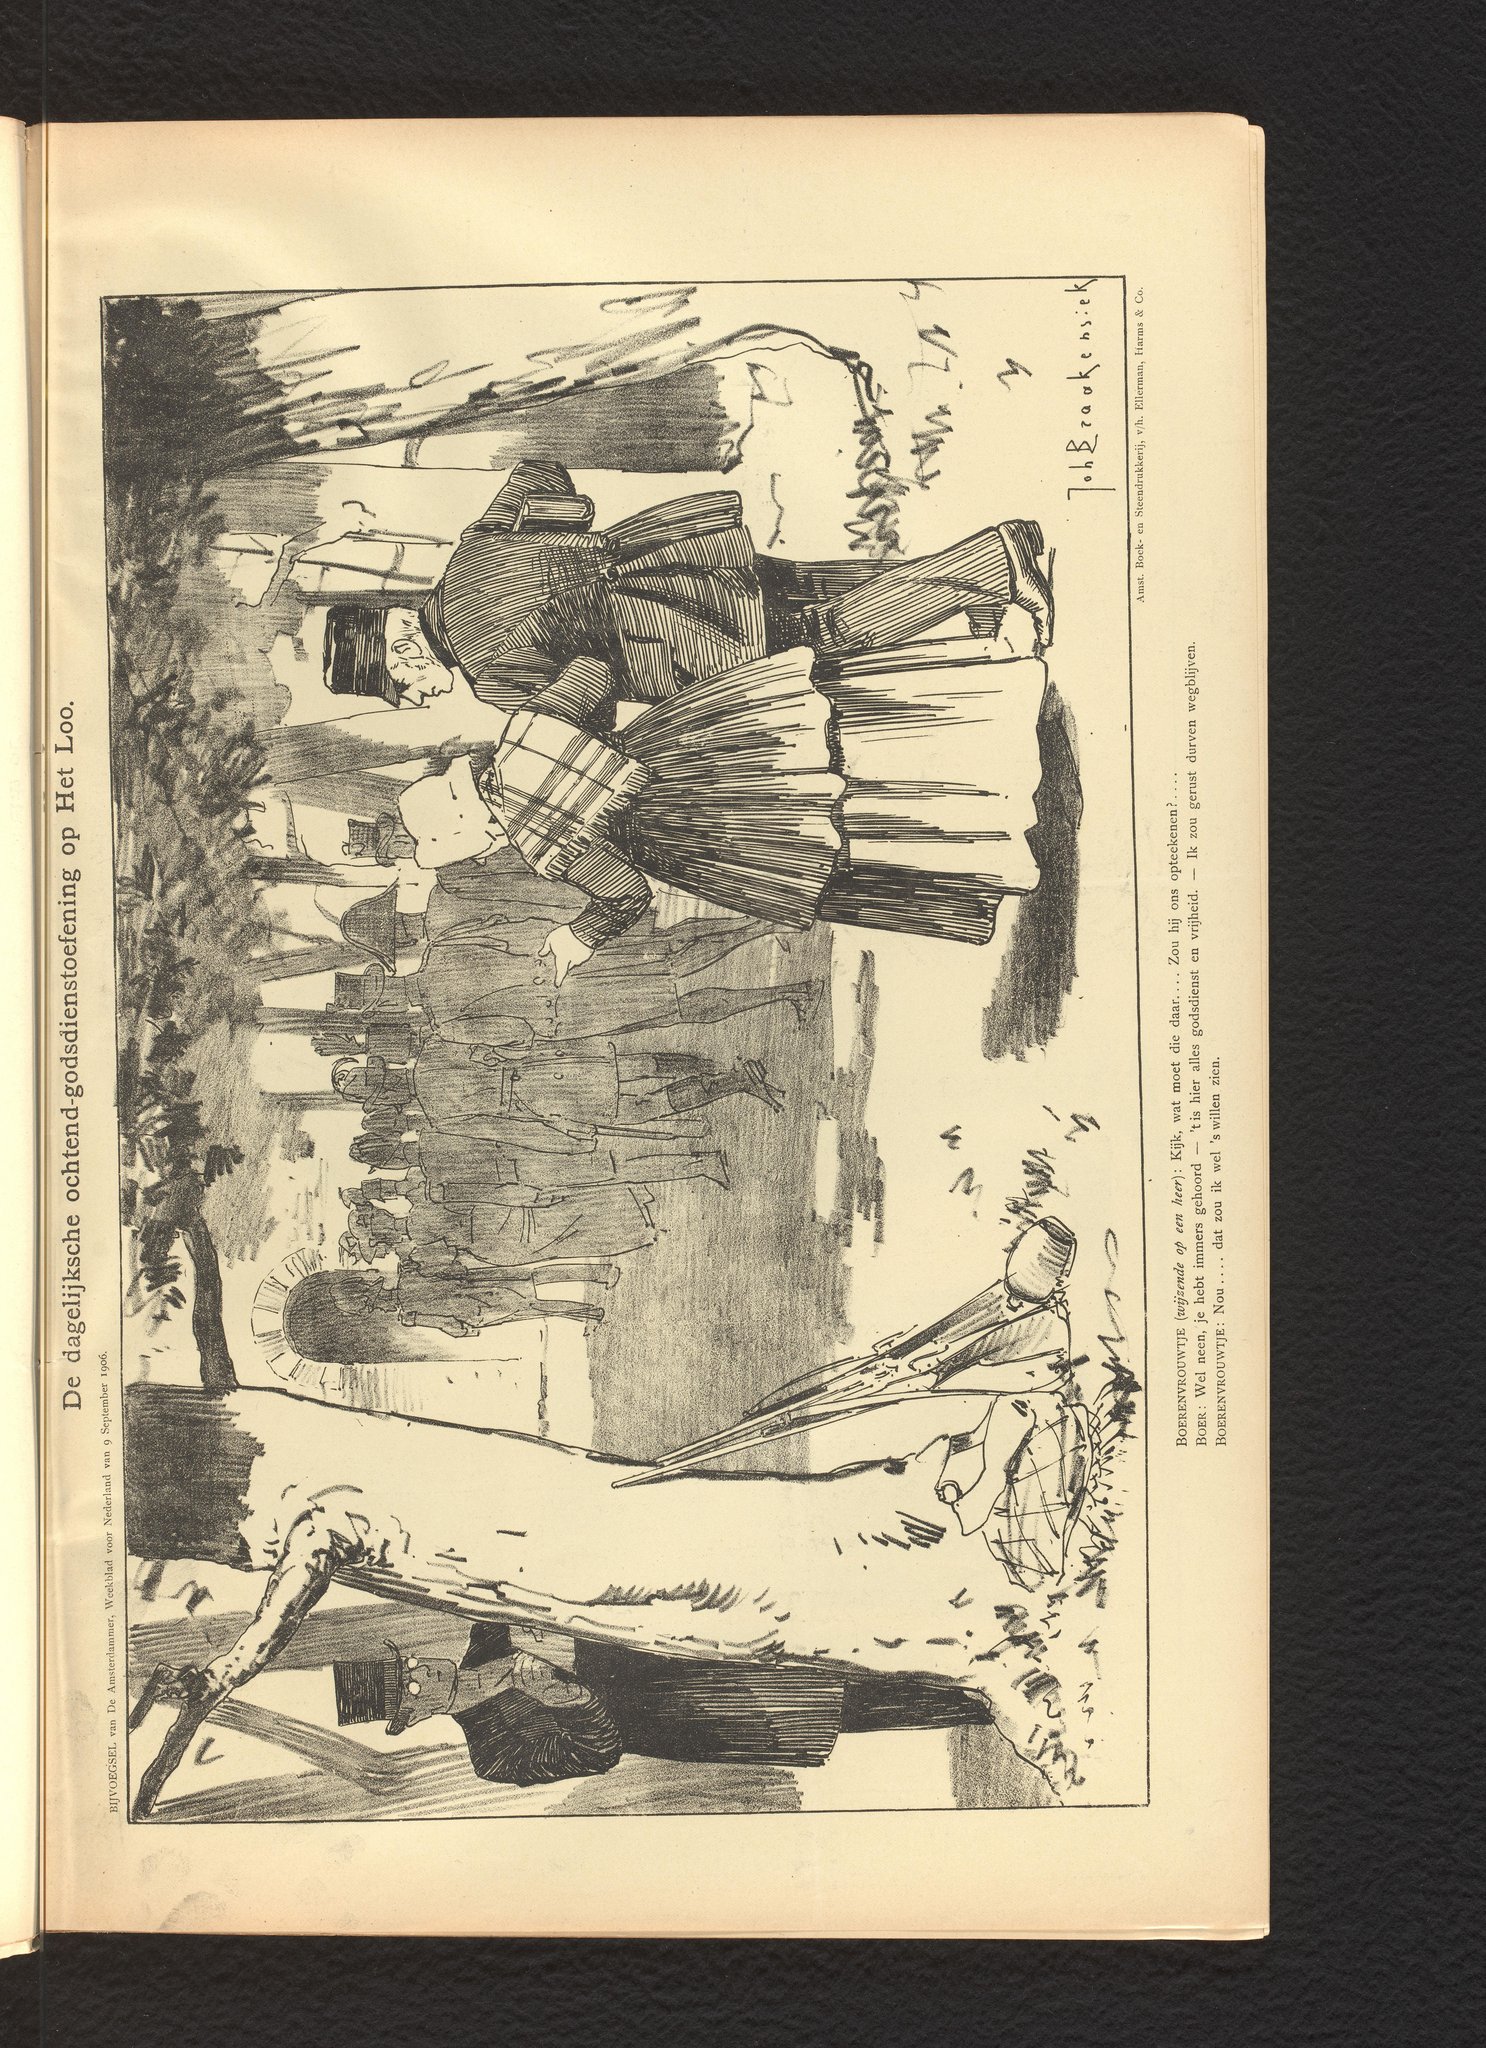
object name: cartoon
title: De dagelijksche ochtend-godsdienstoefening op Het Loo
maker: johan braakensiek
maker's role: draughtsman, print maker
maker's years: 1858-1940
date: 1906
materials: paper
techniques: lithograph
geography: amsterdam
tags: going to church, political caricatures and satires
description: Achteraan een stoet kerkgangers een boerenechtpaar dat opmerkt hoe een man verscholen achter een boom zijn jachtgeweer heeft neergelegd en aantekeningen maakt. Bij Paleis Het Loo.